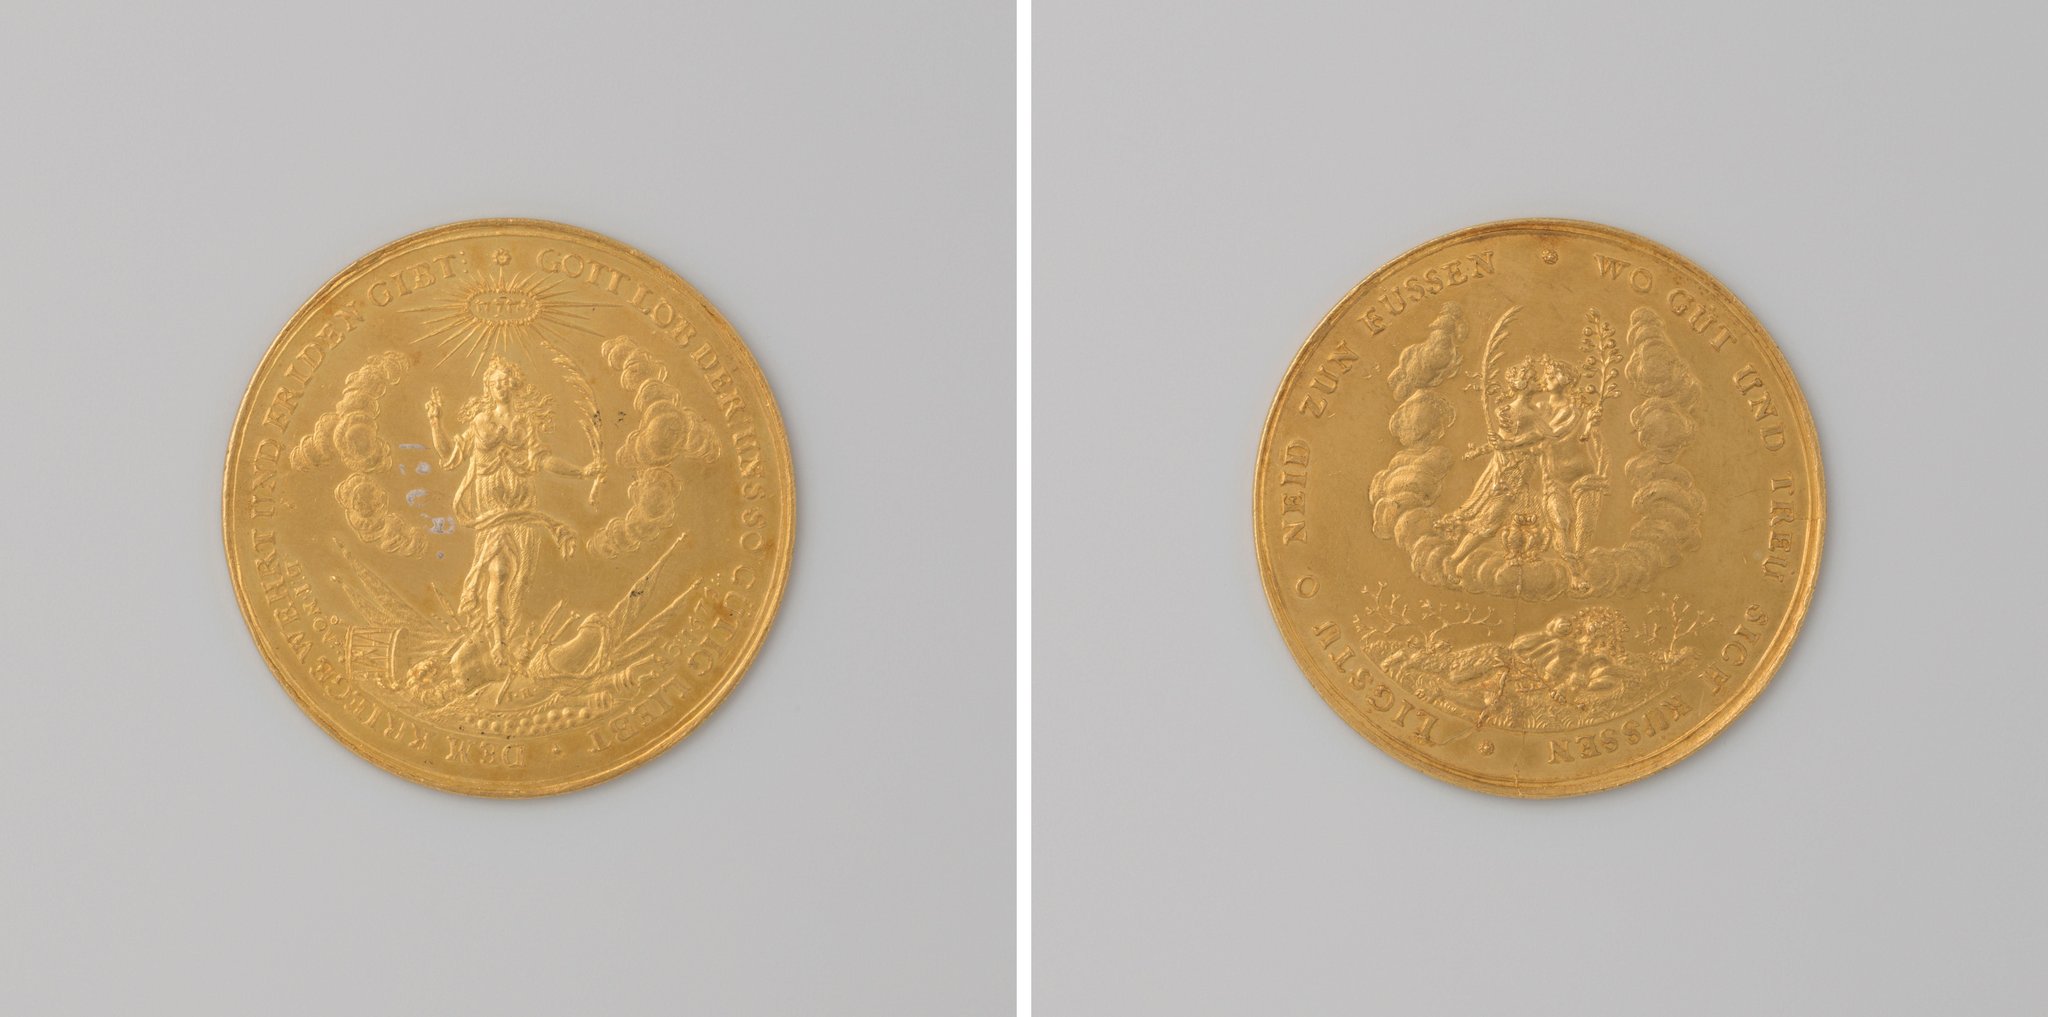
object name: history medal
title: Vrede van Nijmegen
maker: johann christoph reteke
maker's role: medailleur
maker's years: 1664-1720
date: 1611-1679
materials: gold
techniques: striking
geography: hamburg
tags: nijmegen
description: Gouden penning. Voorzijde: Vrede met zegetak staande op Oorlog en krijgstuig beschenen door hemellicht, waarin naam Jehova in Hebreuuwse letters, binnen omschrift. Keerzijde: Vriendschap en Trouw omhelzen elkaar staand op Nijd binnen omschrift